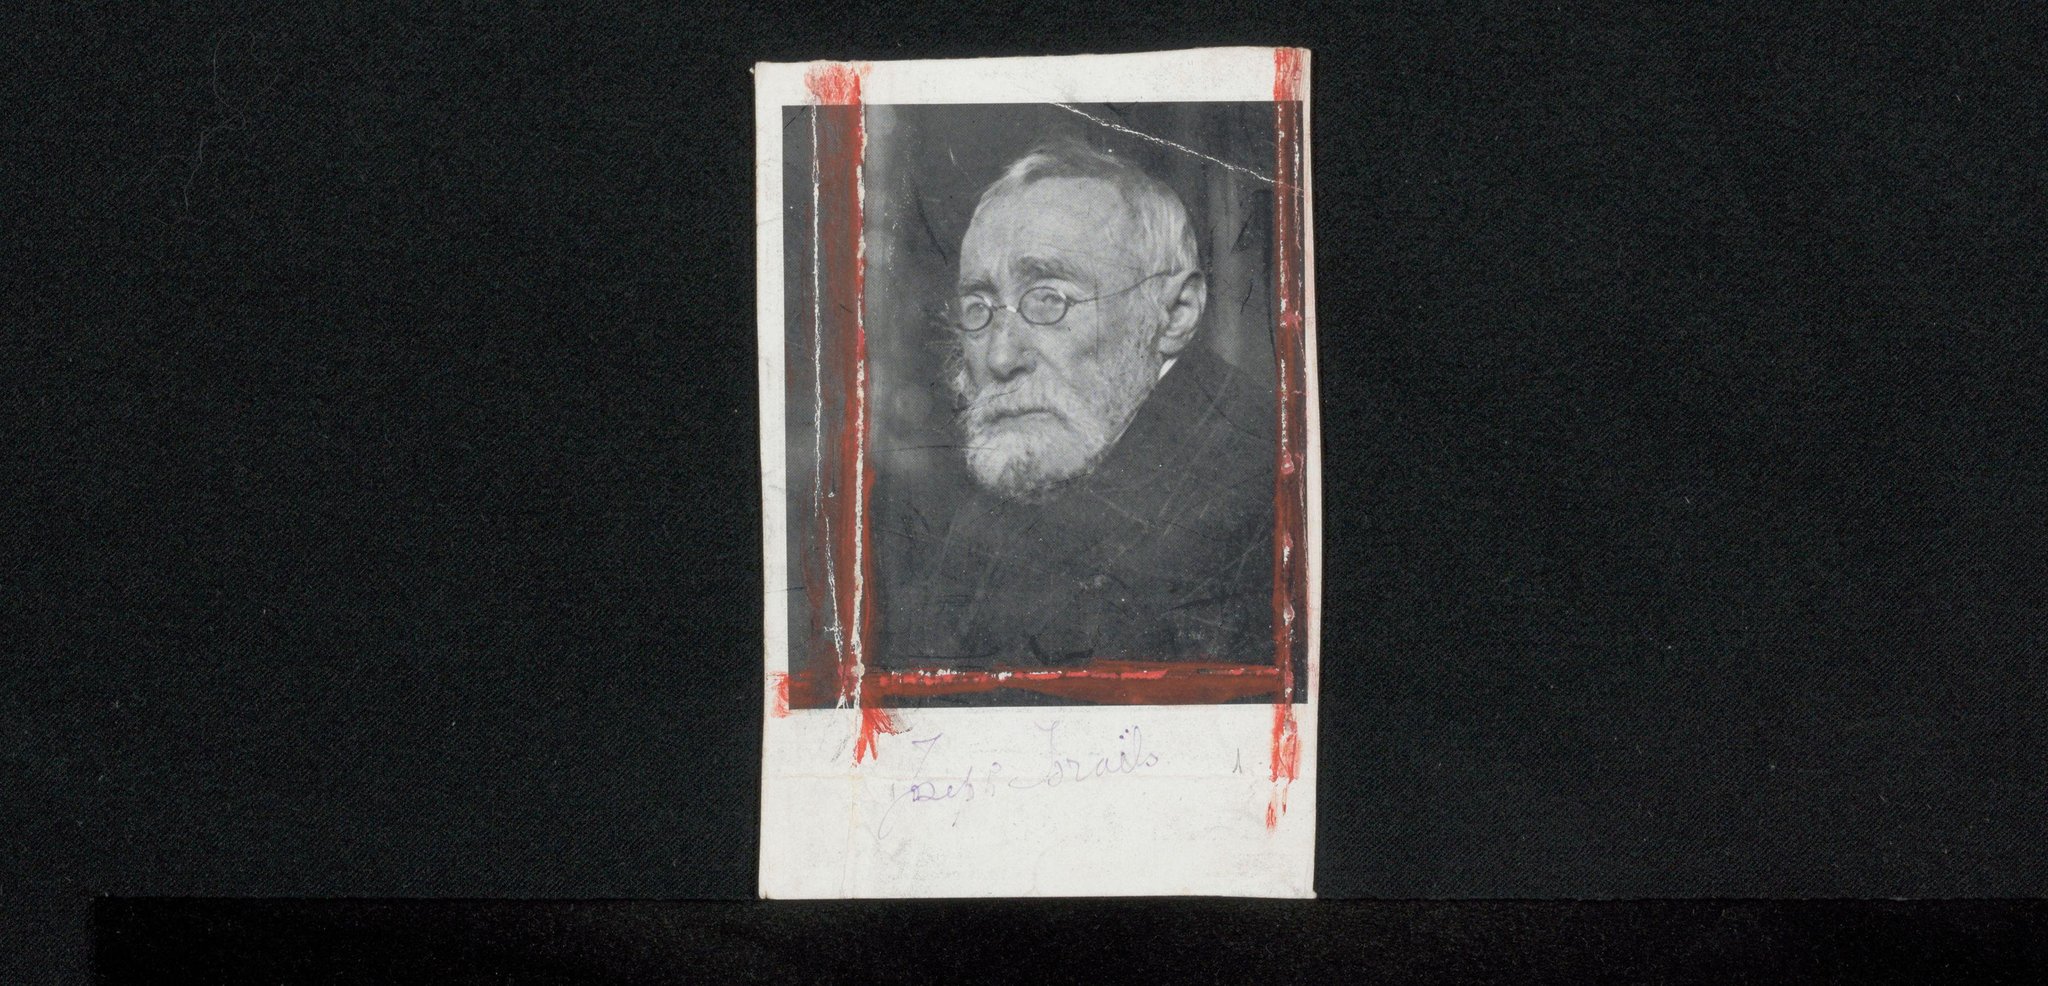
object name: print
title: Portret van Jozef Israëls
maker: Anonymous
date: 1867-1930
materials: paper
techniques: printing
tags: the hague, painter, print maker, draughtsman, jozef israëls, philip zilcken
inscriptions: collector's mark: ‘RPK’